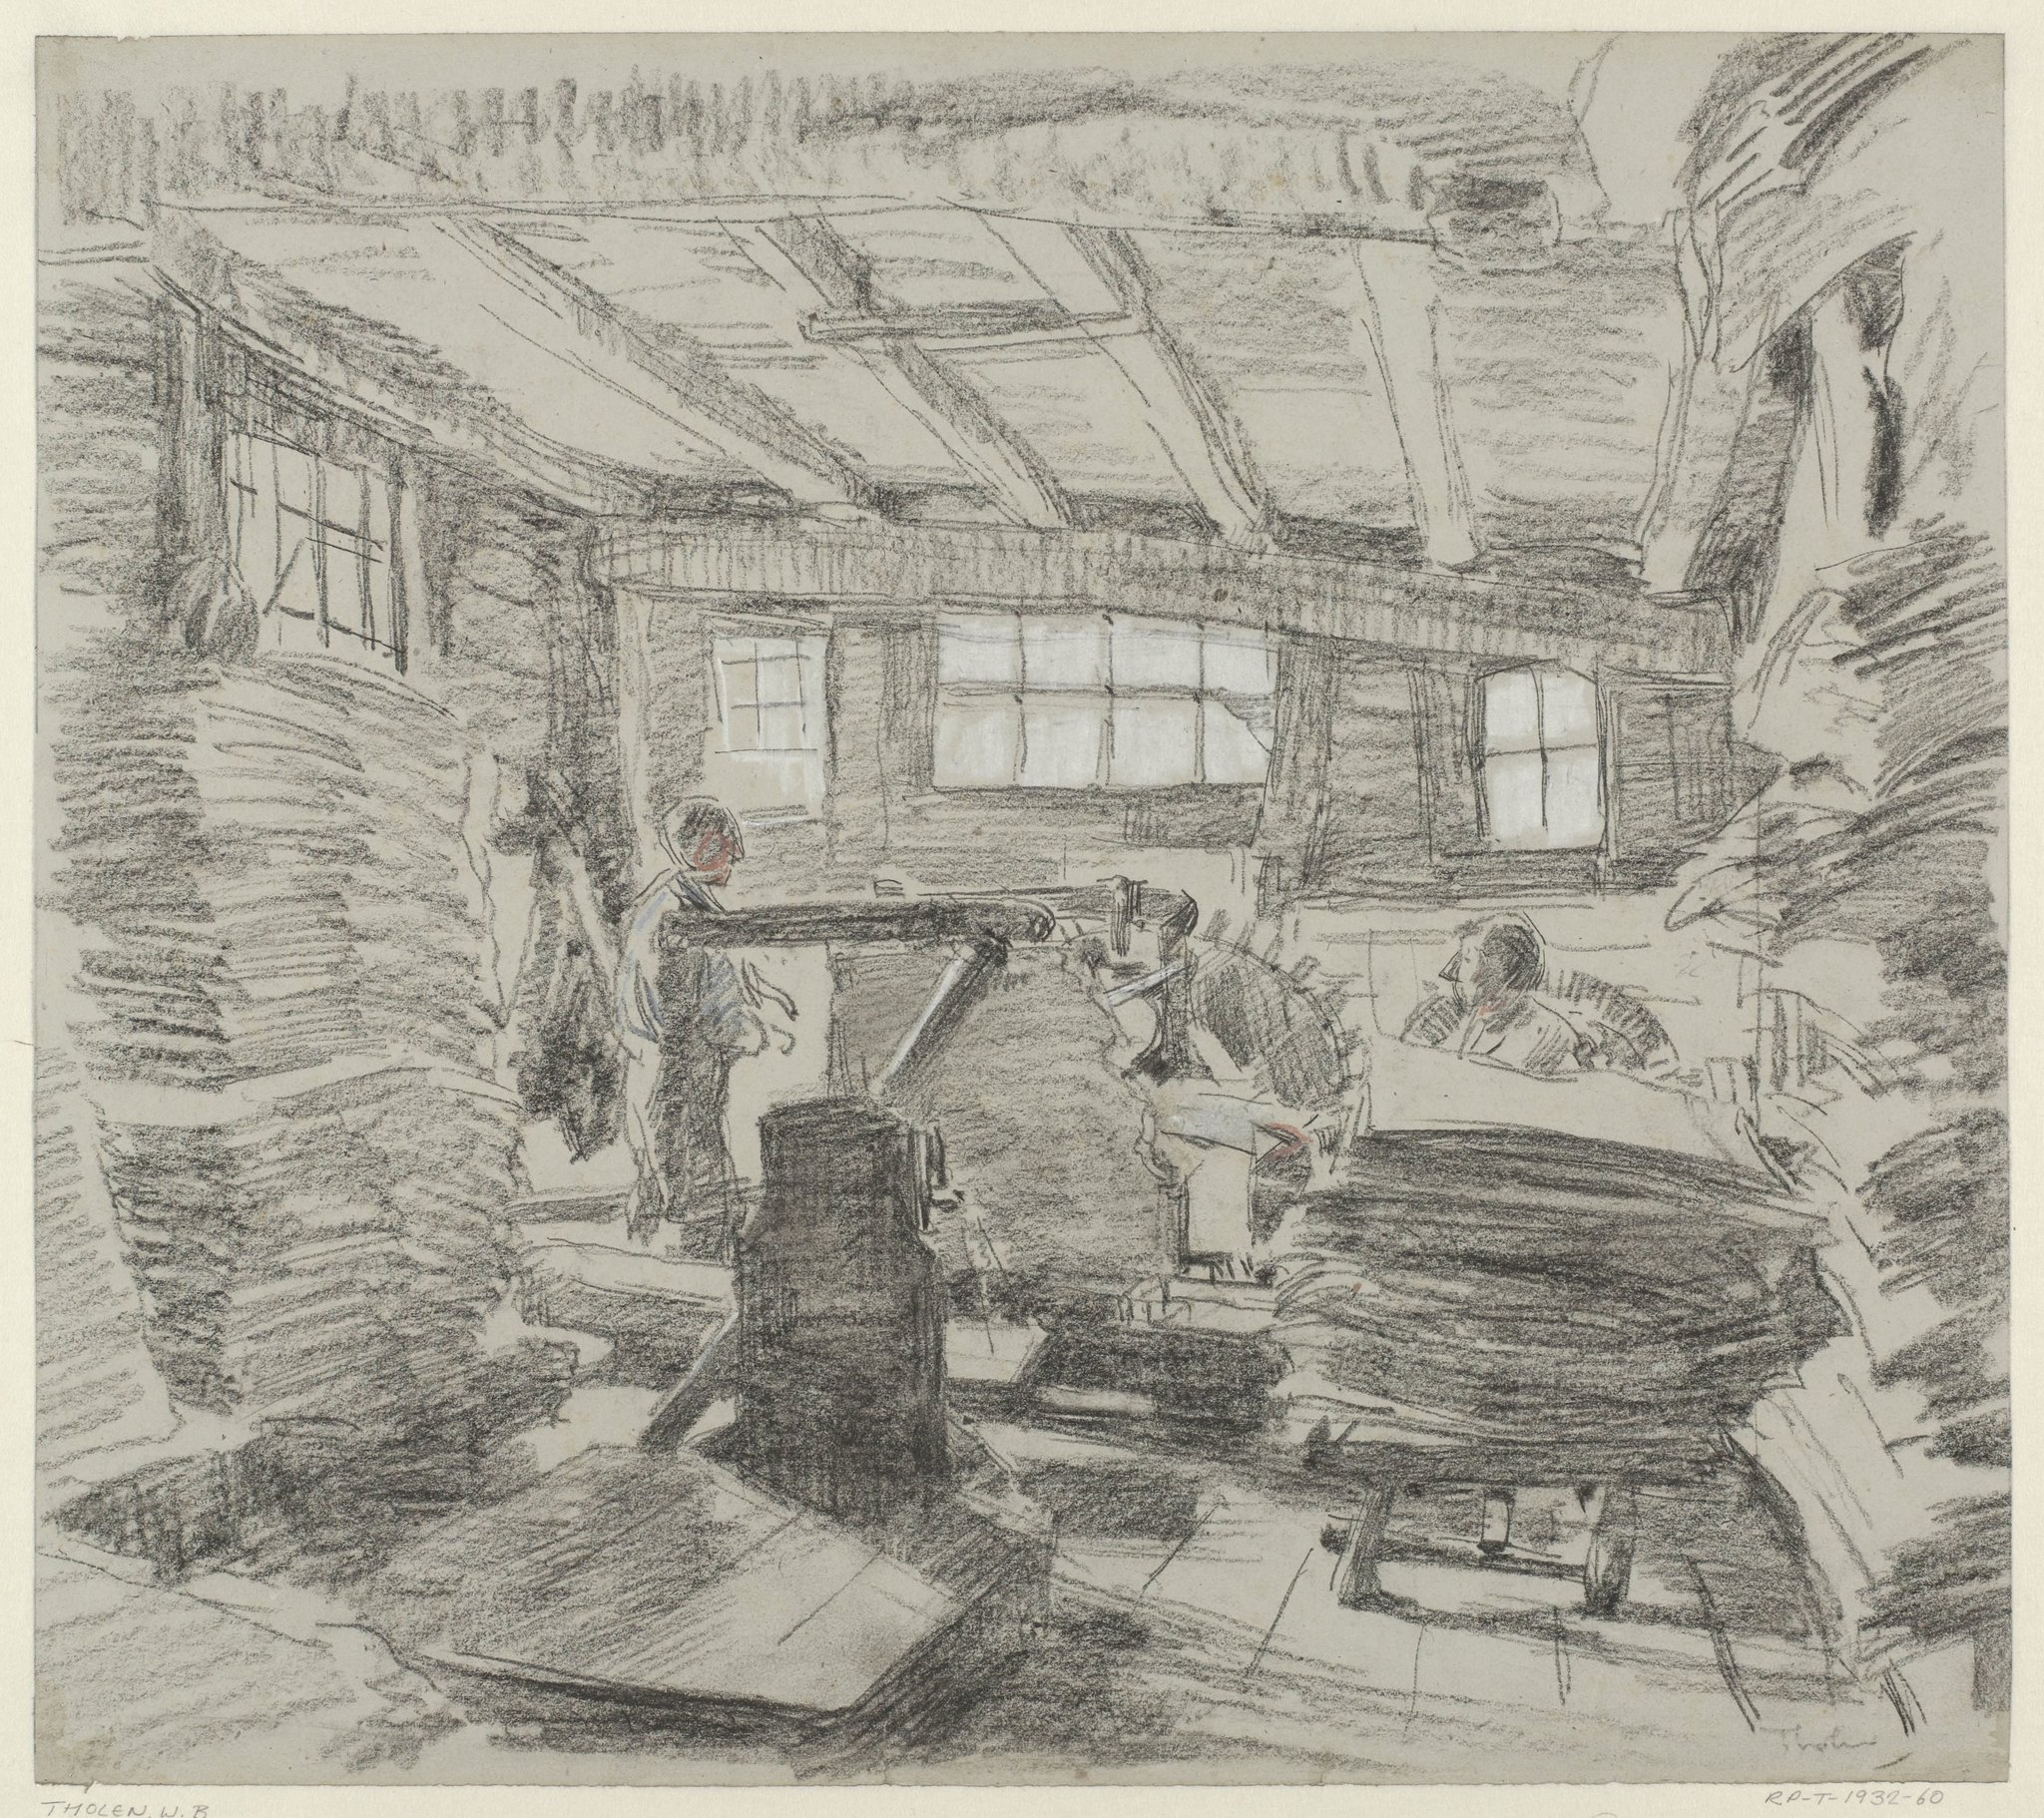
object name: drawing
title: Papierfabriek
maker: willem bastiaan tholen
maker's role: draughtsman, painter, print maker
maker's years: 1860-1931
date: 1870-1931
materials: chalk, paper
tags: other industries ~ plant material, paper (writing material)